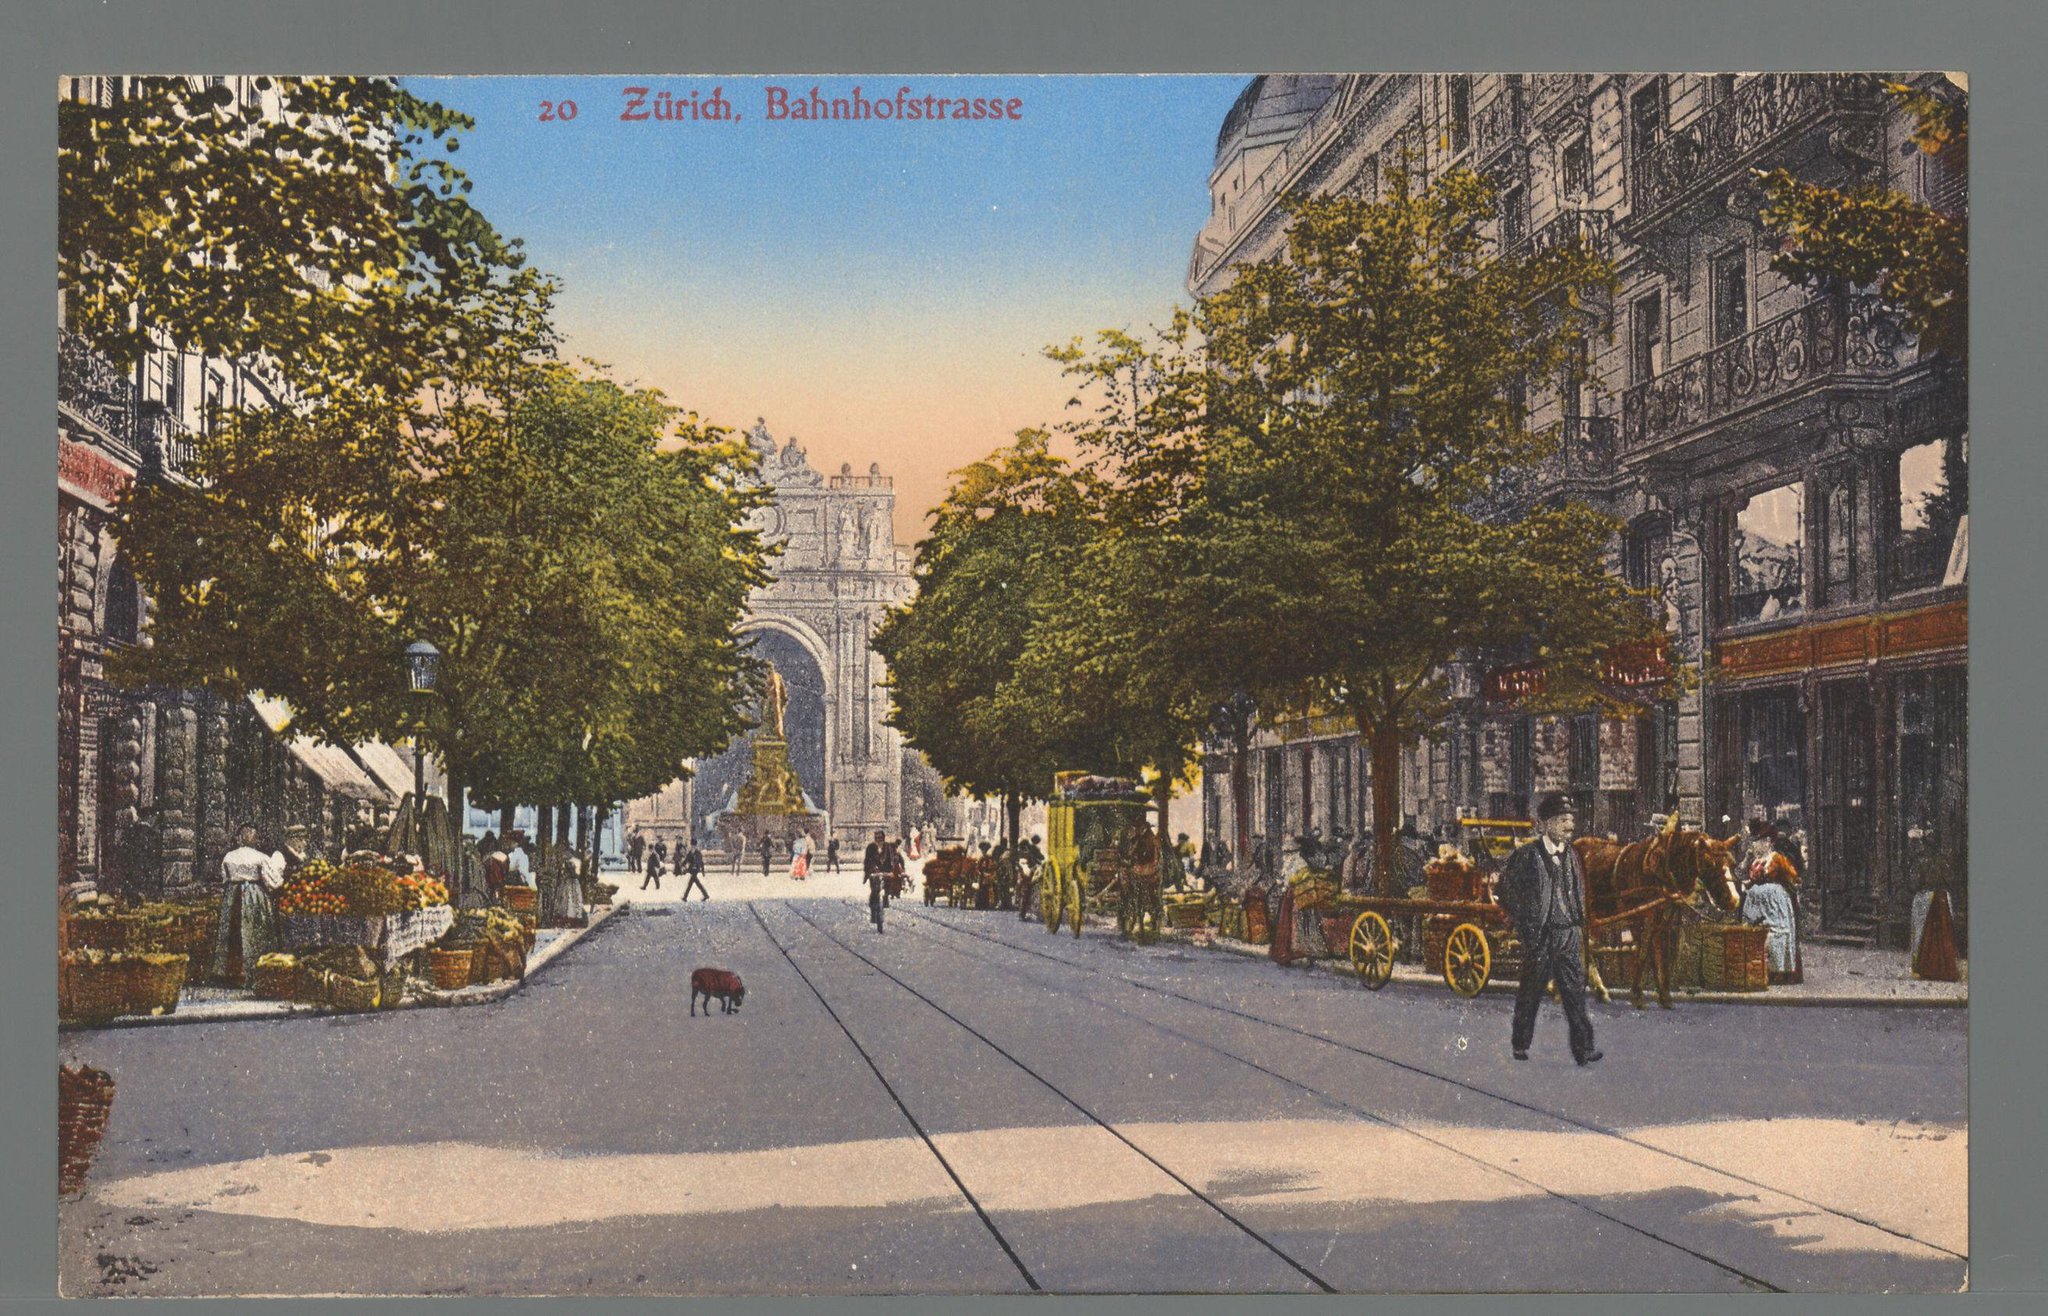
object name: ansichtkaart, prentbriefkaart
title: Zürich, Bahnhofstrasse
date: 1913-1920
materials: cardboard, photographic process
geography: zurich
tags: four-wheeled vehicle drawn by one animal, tramway, tram, street (+ city(-scape) with figures, staffage)